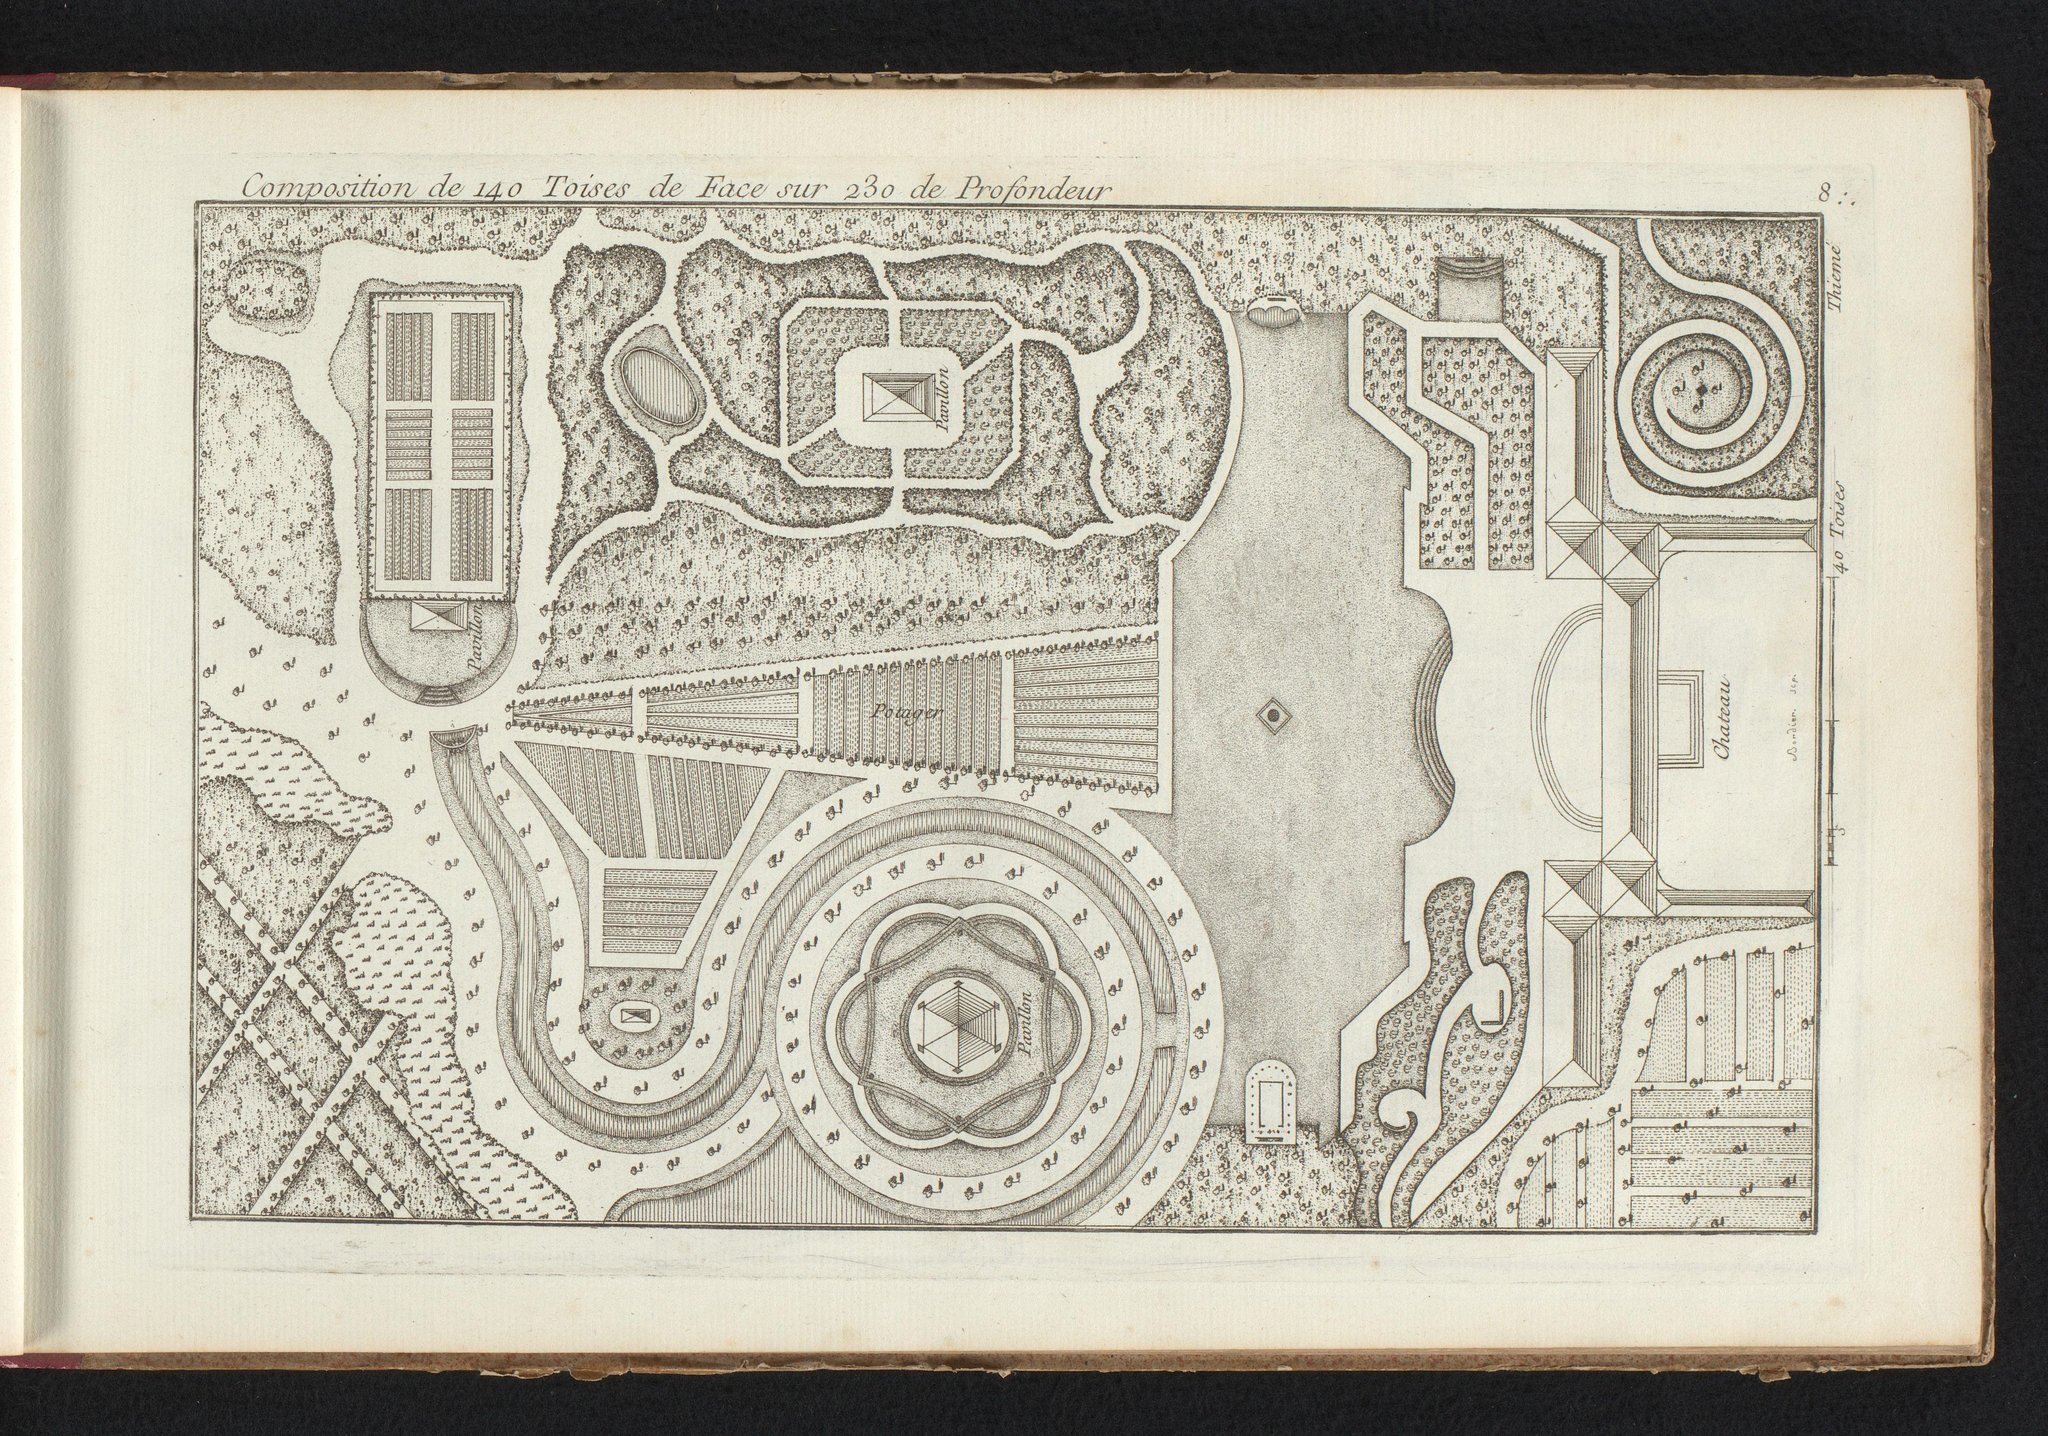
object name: print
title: Composition de 140 toises de face sur 230 de profondeur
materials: paper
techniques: engraving, etching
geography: paris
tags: plan, map of garden, lay-out of garden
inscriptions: collector's mark: Lugt 2760, collector's mark: Lugt 2228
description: De serie 'Jardins anglo-chinois à la mode' verscheen in totaal in 21 zogeheten 'cahiers' (afleveringen). De huidige prent komt uit het derde 'cahier'. Het Rijksmuseum Amsterdam bezit drie banden met daarin in totaal zes 'cahiers' van deze reeks. In de documentatie wordt verwezen naar een in de bibliotheek van het Rijksmuseum Amsterdam aanwezige facsimile van het complete werk.